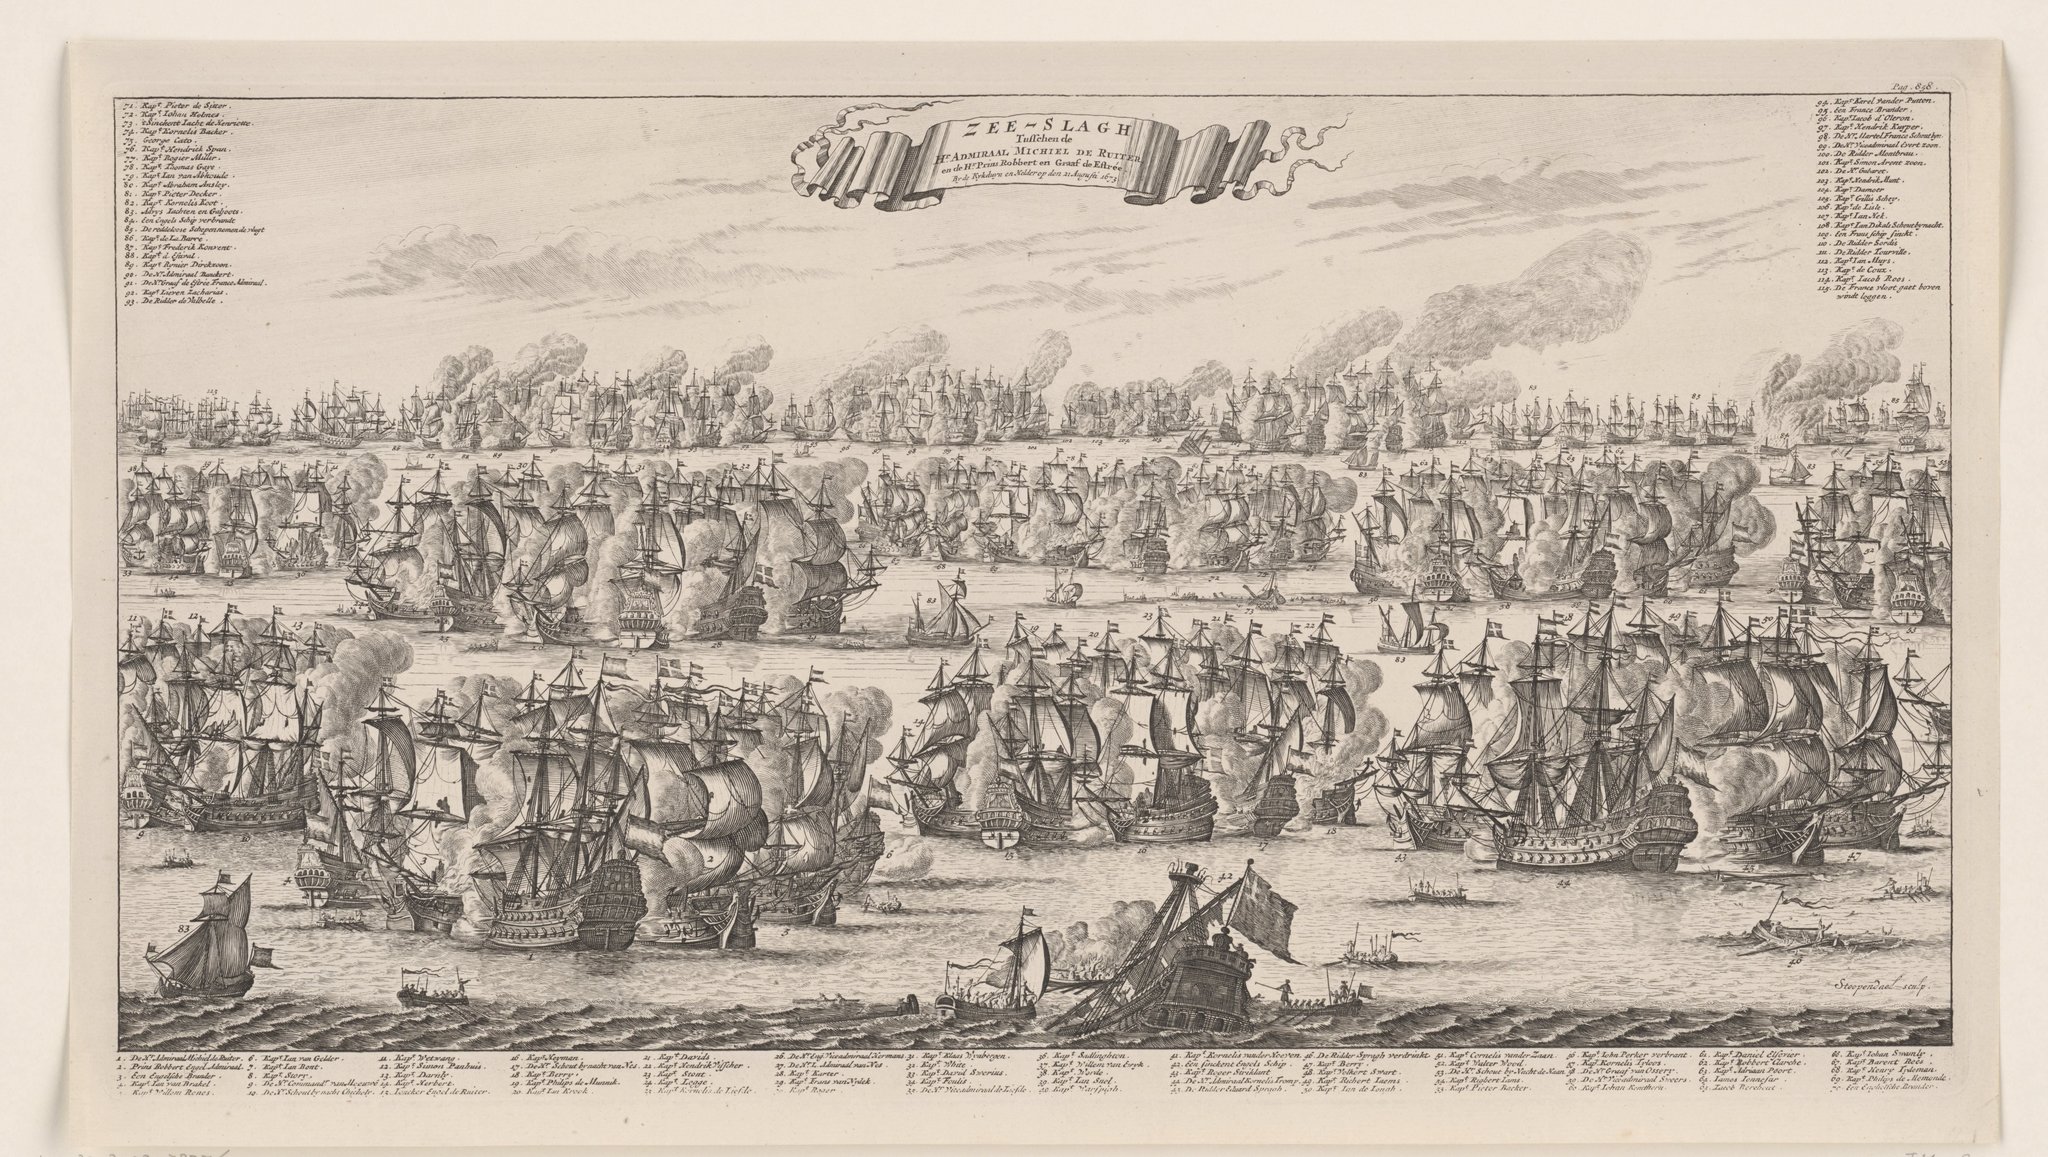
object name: history print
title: Zeeslag bij Kijkduin, 1673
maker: bastiaen stopendael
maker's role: print maker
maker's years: 1636-1693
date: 1685-1687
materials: paper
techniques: engraving, etching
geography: northern netherlands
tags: prague, london, painter, print maker, draughtsman, prinz ruprecht, flushing, michiel adriaenszoon de ruyter, rotterdam, amsterdam, cornelis tromp, battle (+ naval force), battle of the texel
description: Zeeslag bij Kijkduin, 21 augustus 1673. Zeeslag voor Kijkduin bij Den Helder en Texel tussen de Staatse vloot onder Michiel Adriaenszoon de Ruyter en Cornelis Tromp en de gecombineerde Engels-Franse vloot onder prins Rupert en de graaf Jean d'Estrées (II). Onderaan en bovenaan de legenda 1-115 in 3 delen.